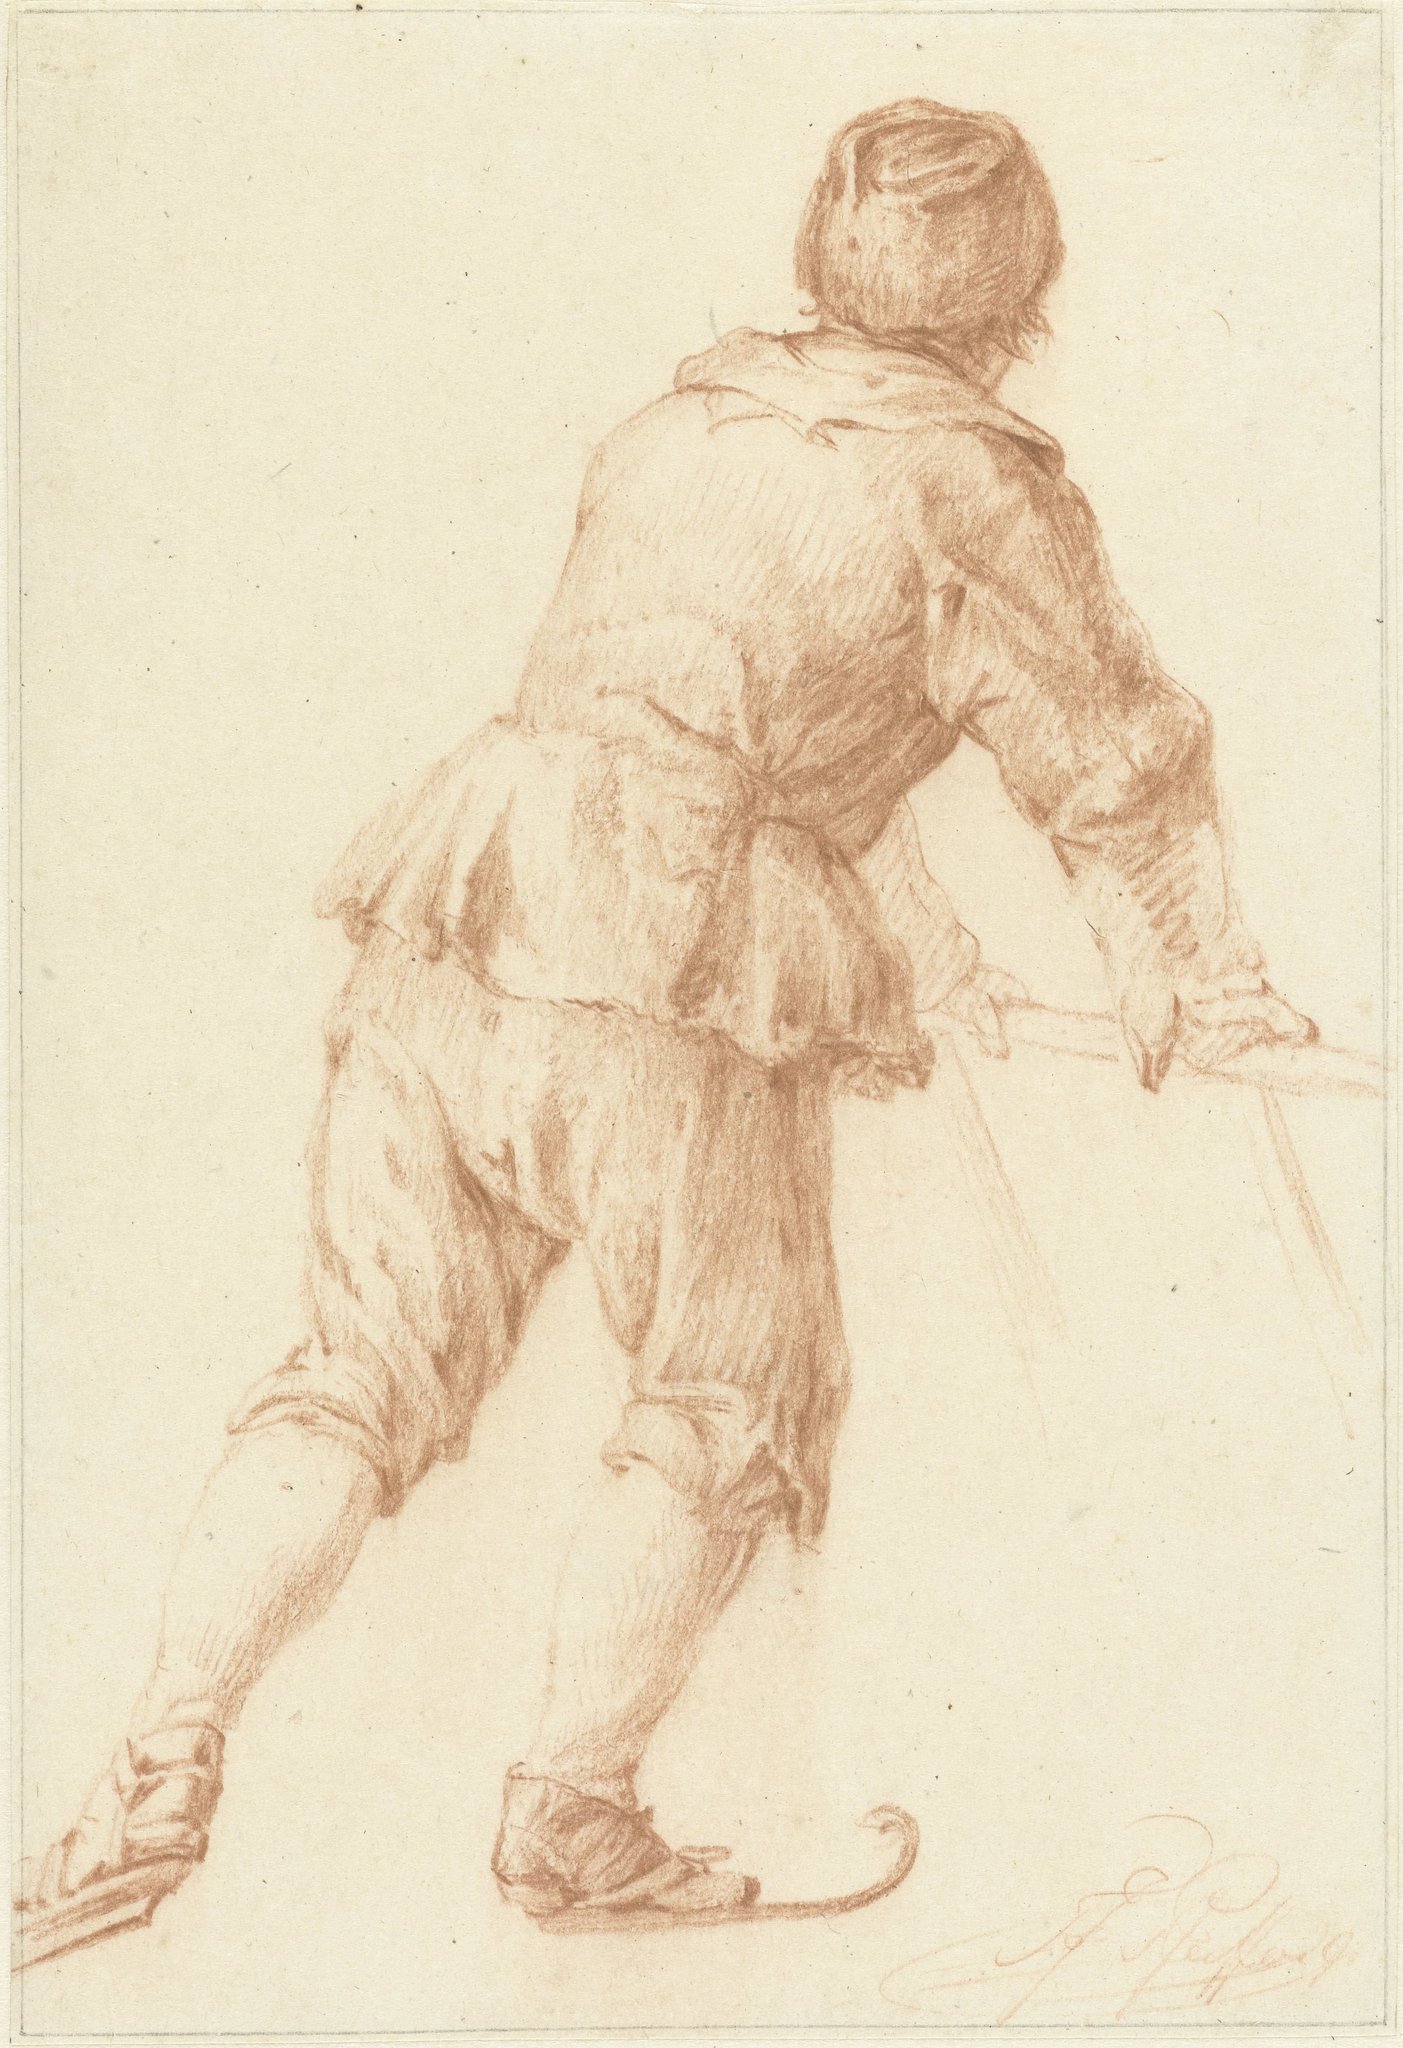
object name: drawing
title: Schaatsende jongen die een slee voor zich uit schuift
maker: françois joseph pfeiffer (ii)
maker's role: draughtsman, print maker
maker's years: 1778-1835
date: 1788-1835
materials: chalk, paper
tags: skates (winter sports)